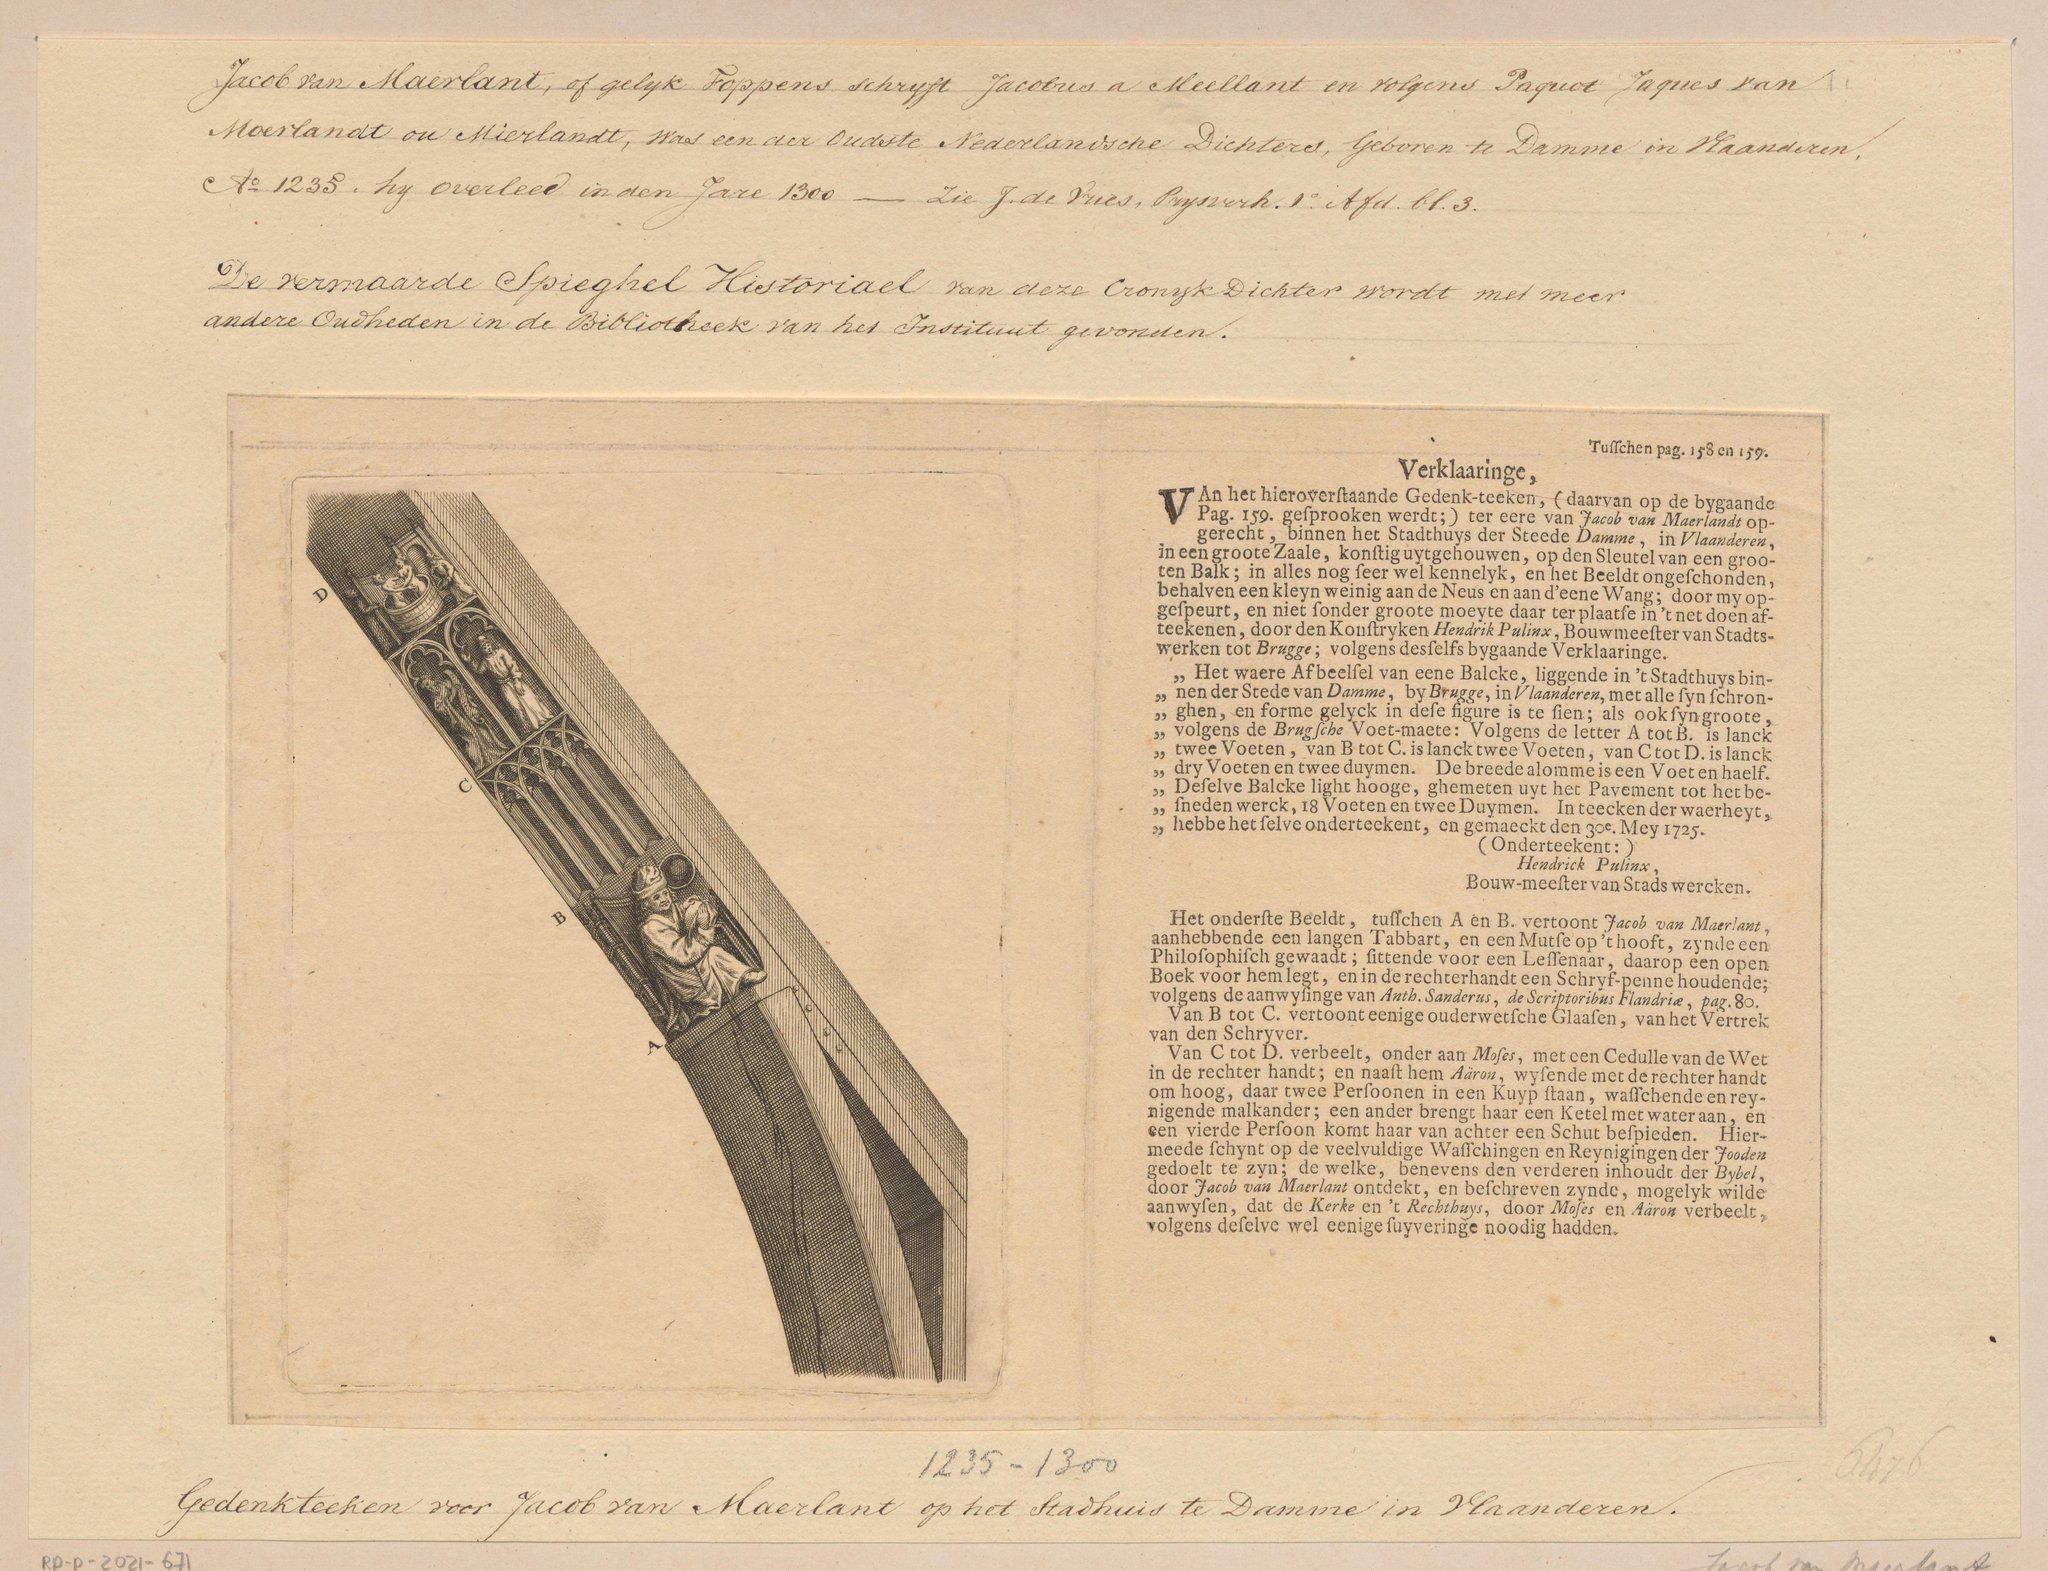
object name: book illustration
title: Gedenkteken ter ere van Jacob van Maerlant in hout gesneden in het stadhuis van Damme en toelichting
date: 1732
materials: paper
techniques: engraving, letterpress printing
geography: amsterdam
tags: other memorial structures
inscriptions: tekst, recto opzetvel, handgeschreven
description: Prent uit: Long, Isaäc de. Boek-zaal der nederduytsche Bybels, geopent, in een historische verhandelinge van de oversettinge der heylingen schriftuure in de nederduytsche taale. Amsterdam: Hendrik Vieroot, 1732.